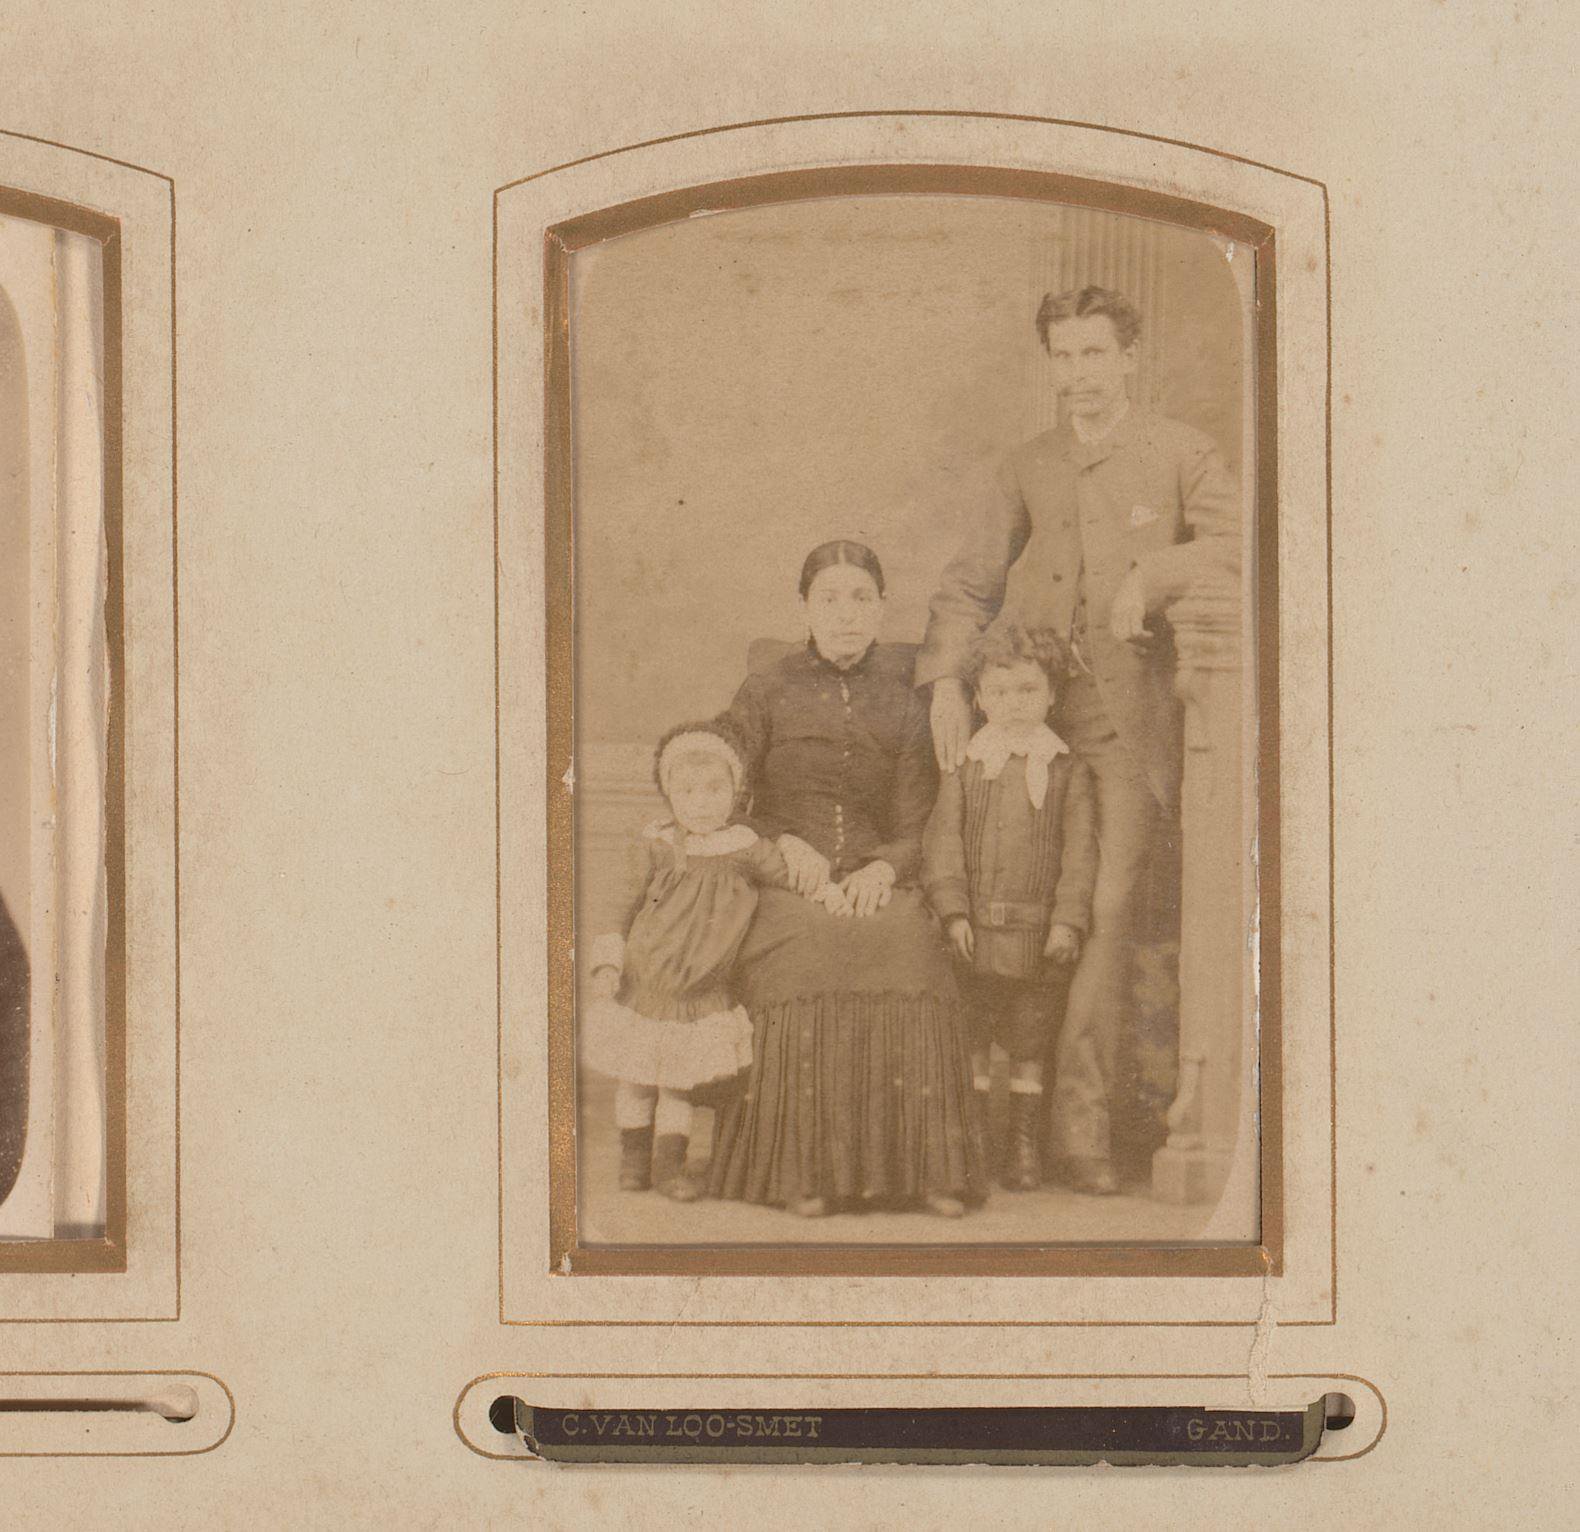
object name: album leaf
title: Familieportret van een zittende vrouw, een staande man en twee kinderen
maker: charles van loo-smet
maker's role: fotograaf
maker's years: 1846-1904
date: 1877-1887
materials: cardboard, celluloid, photographic support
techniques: albumen print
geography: ghent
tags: family group, especially parents with their child(ren), child (+ two persons), anonymous historical persons portrayed in a group, in a group-portrait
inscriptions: annotation: ‘er is maar een liever/ niet schoon op st[.]dda[.]/ is mijne Vrouw a mij moete/ niet zien om dat ik zoo/ vet gewoarden ben het is/ mijn schuld niet’, inscription: ‘C. van Loo-Smet/ ARTISTE PEINTRE/ DESSINATEUR/ Atelier/ de Photographie/ en tous genres/ Rue Longue des Violettes, 76,/ GAND./ Les Clichés seront conservés.’